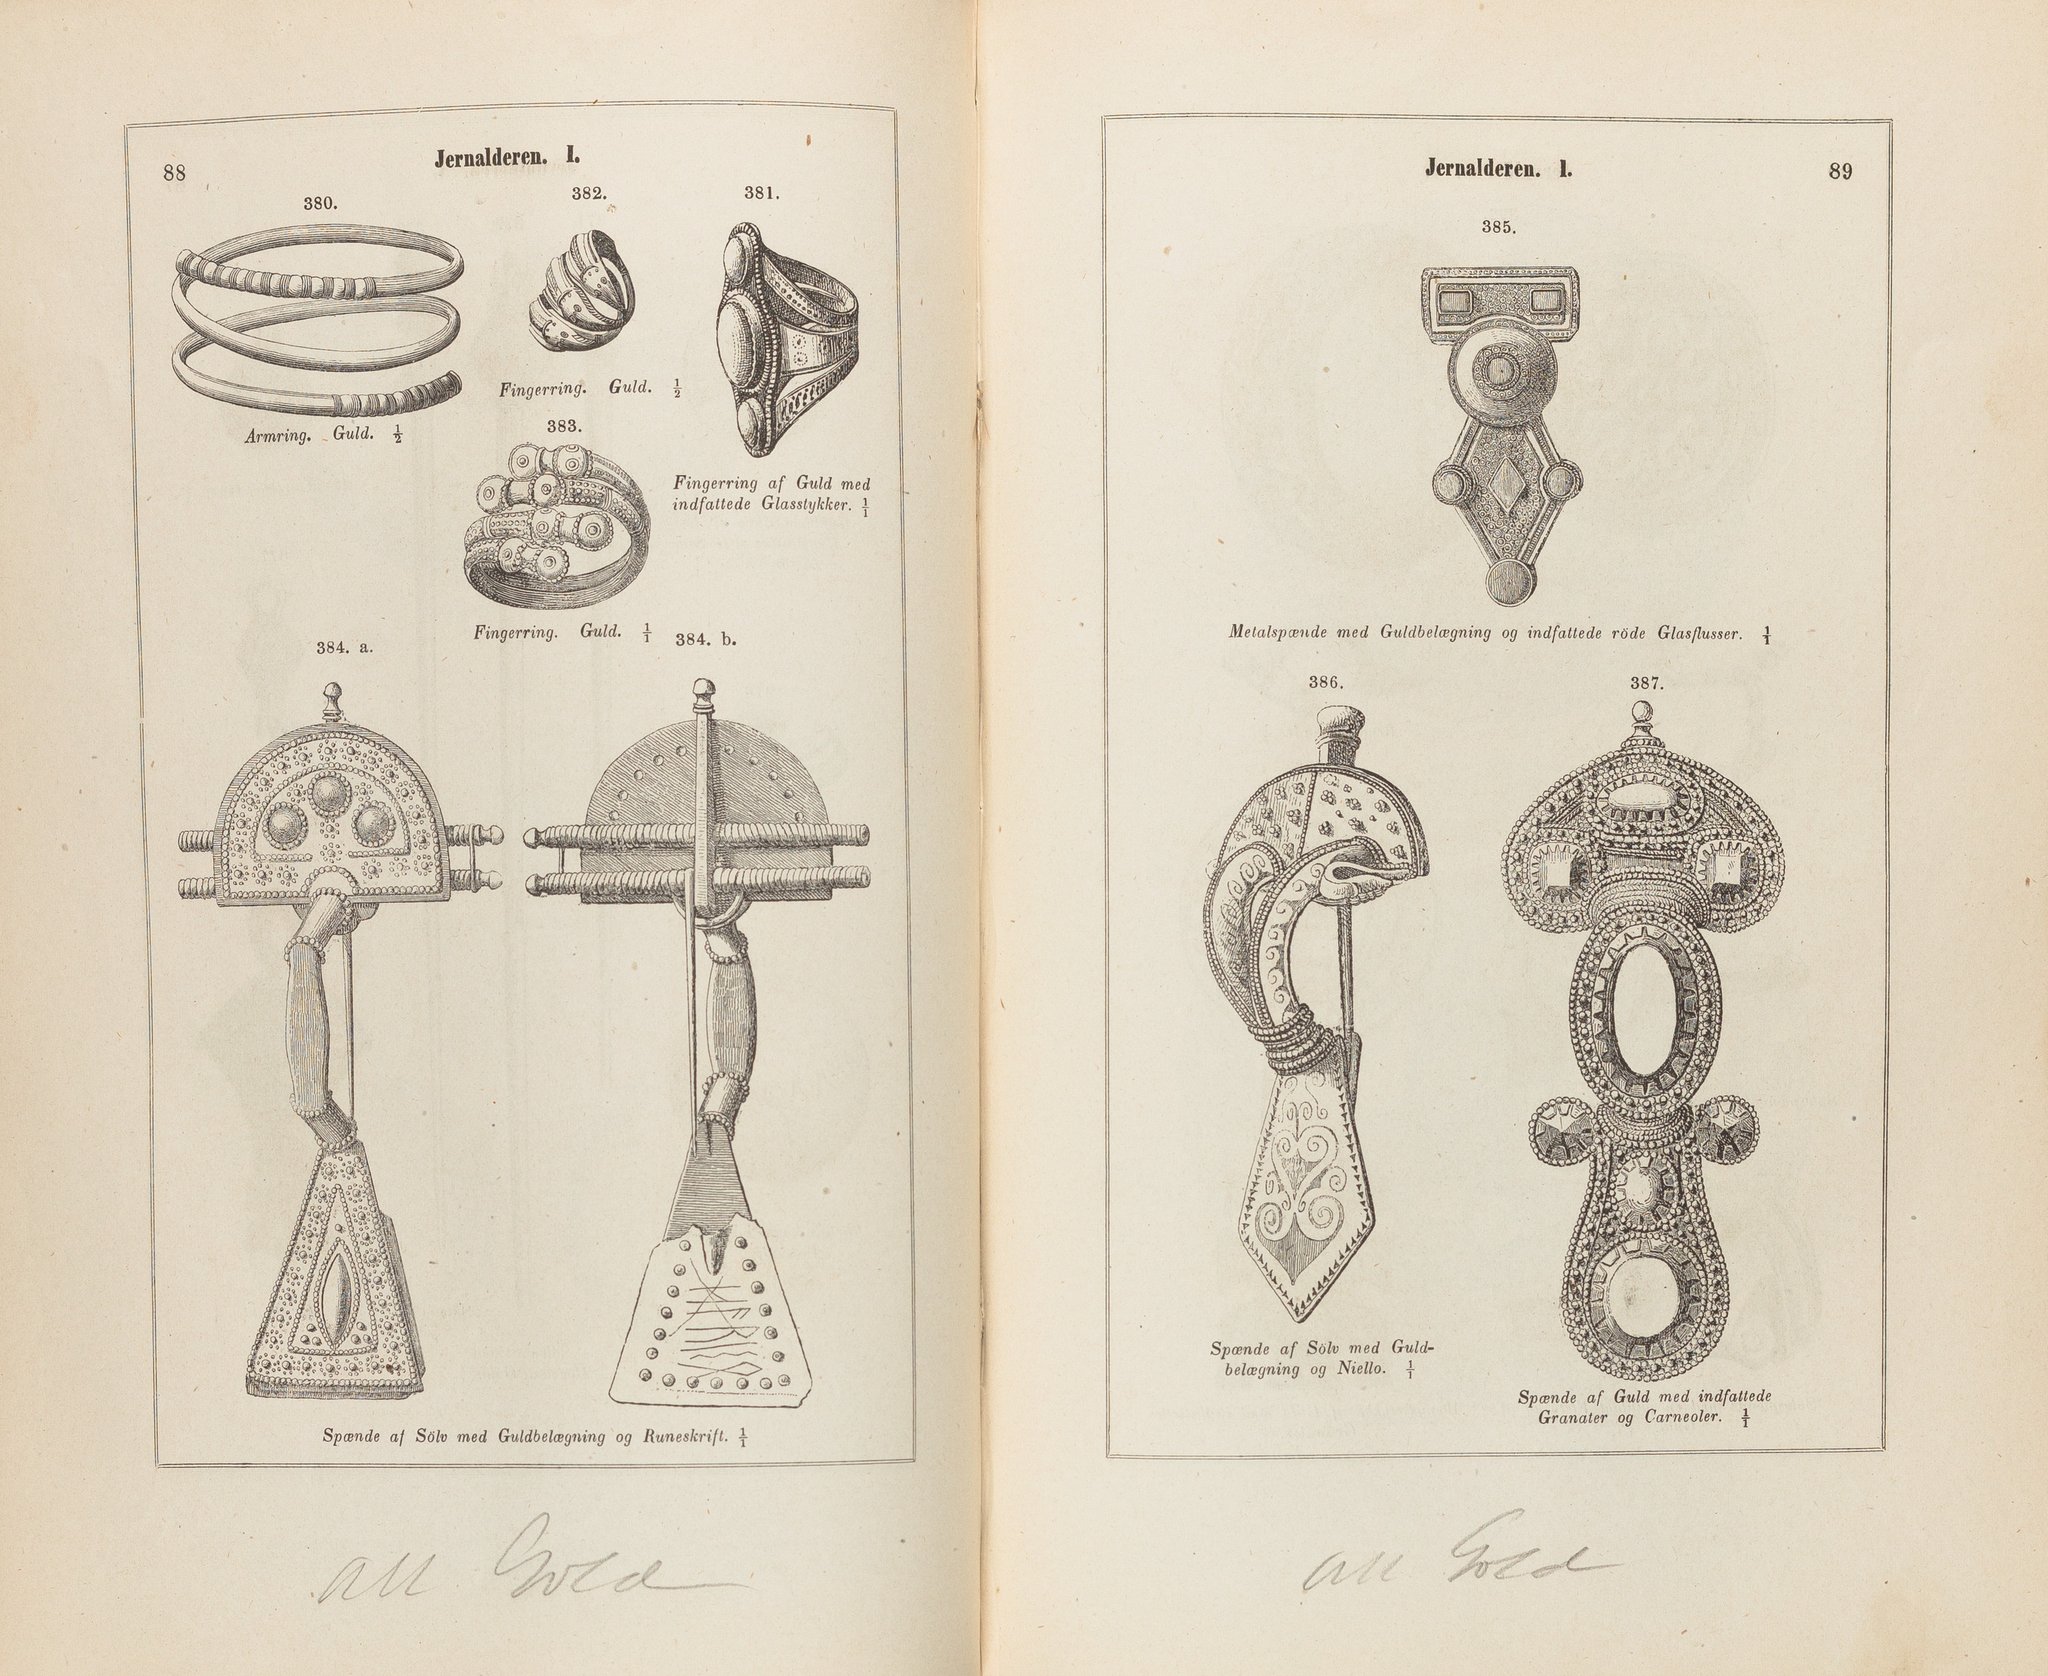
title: Nordiske oldsager i det Kongelige museum i Kjöbenhavn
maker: jens jacob asmussen worsaae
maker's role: author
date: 1859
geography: denmark